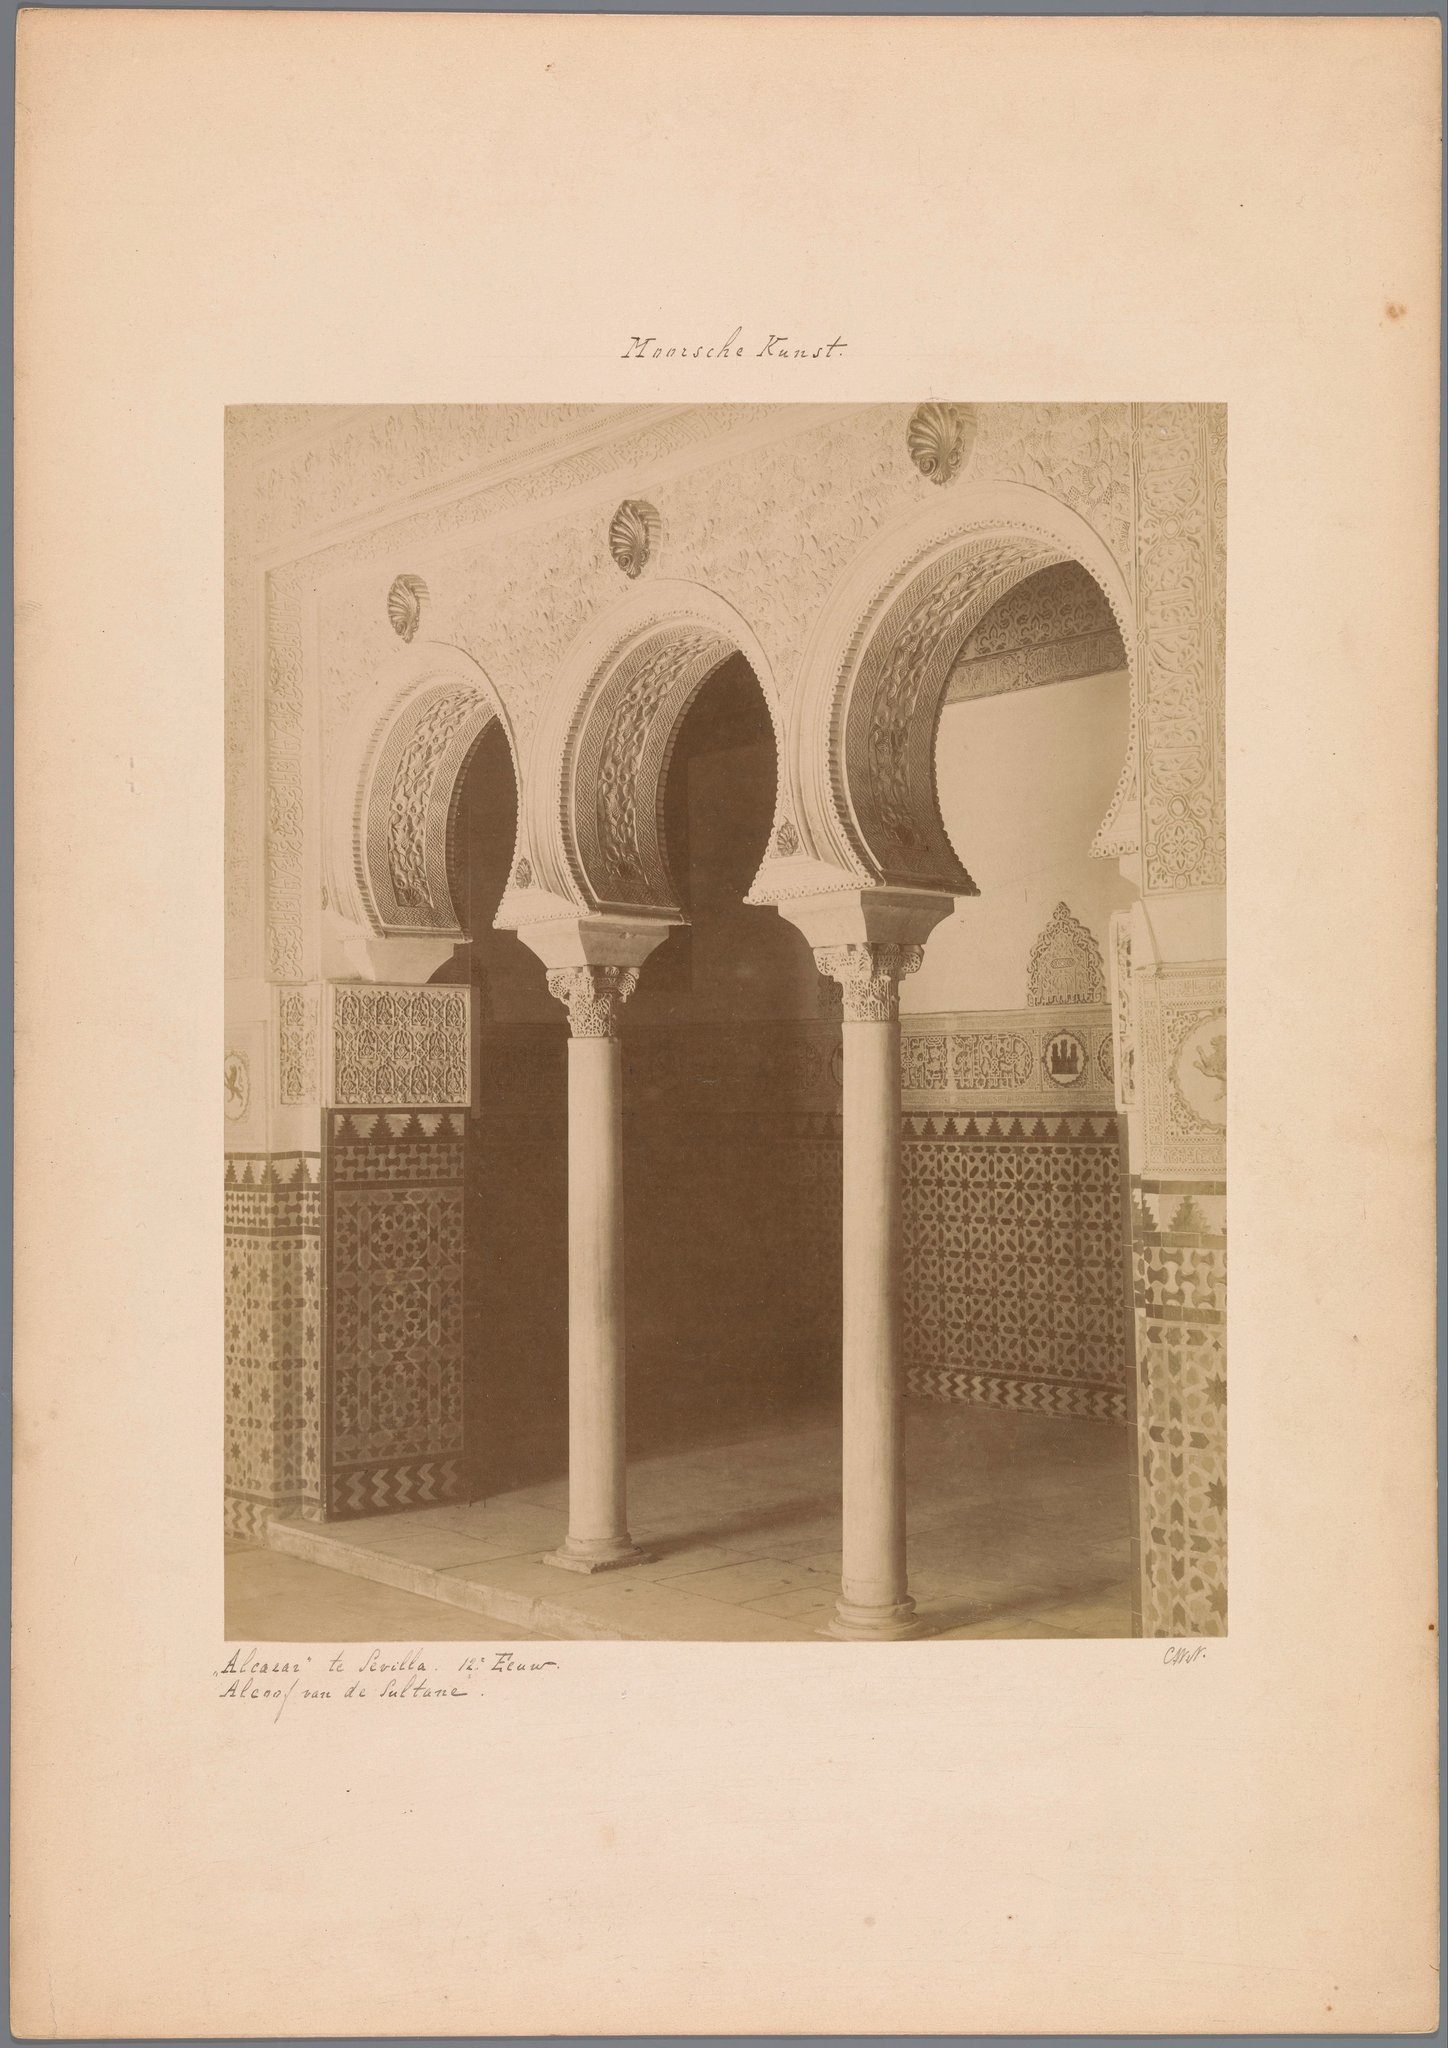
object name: photograph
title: ,,Alcazar"te Sevilla.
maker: Anonymous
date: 1875-1900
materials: cardboard, photographic support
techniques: albumen print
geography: royal palace of seville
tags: flat decoration ~ applied arts (+ islamic art), arch, archivolt ~ architecture, palace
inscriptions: inscription: ‘CWN.’, inscription: ‘Moorsche Kunst.’, collector's mark: ‘KUNSTNIJVERHEIDSCHOOL QUELLINUS AMSTERDAM FRANS HALSSTRAAT 14.’, collector's mark: ‘INSTITUUT VOOR KUNST-NIJVERHEIDSONDERWIJS GABRIËL METSUSTRAAT No. 16 AMSTERDAM’